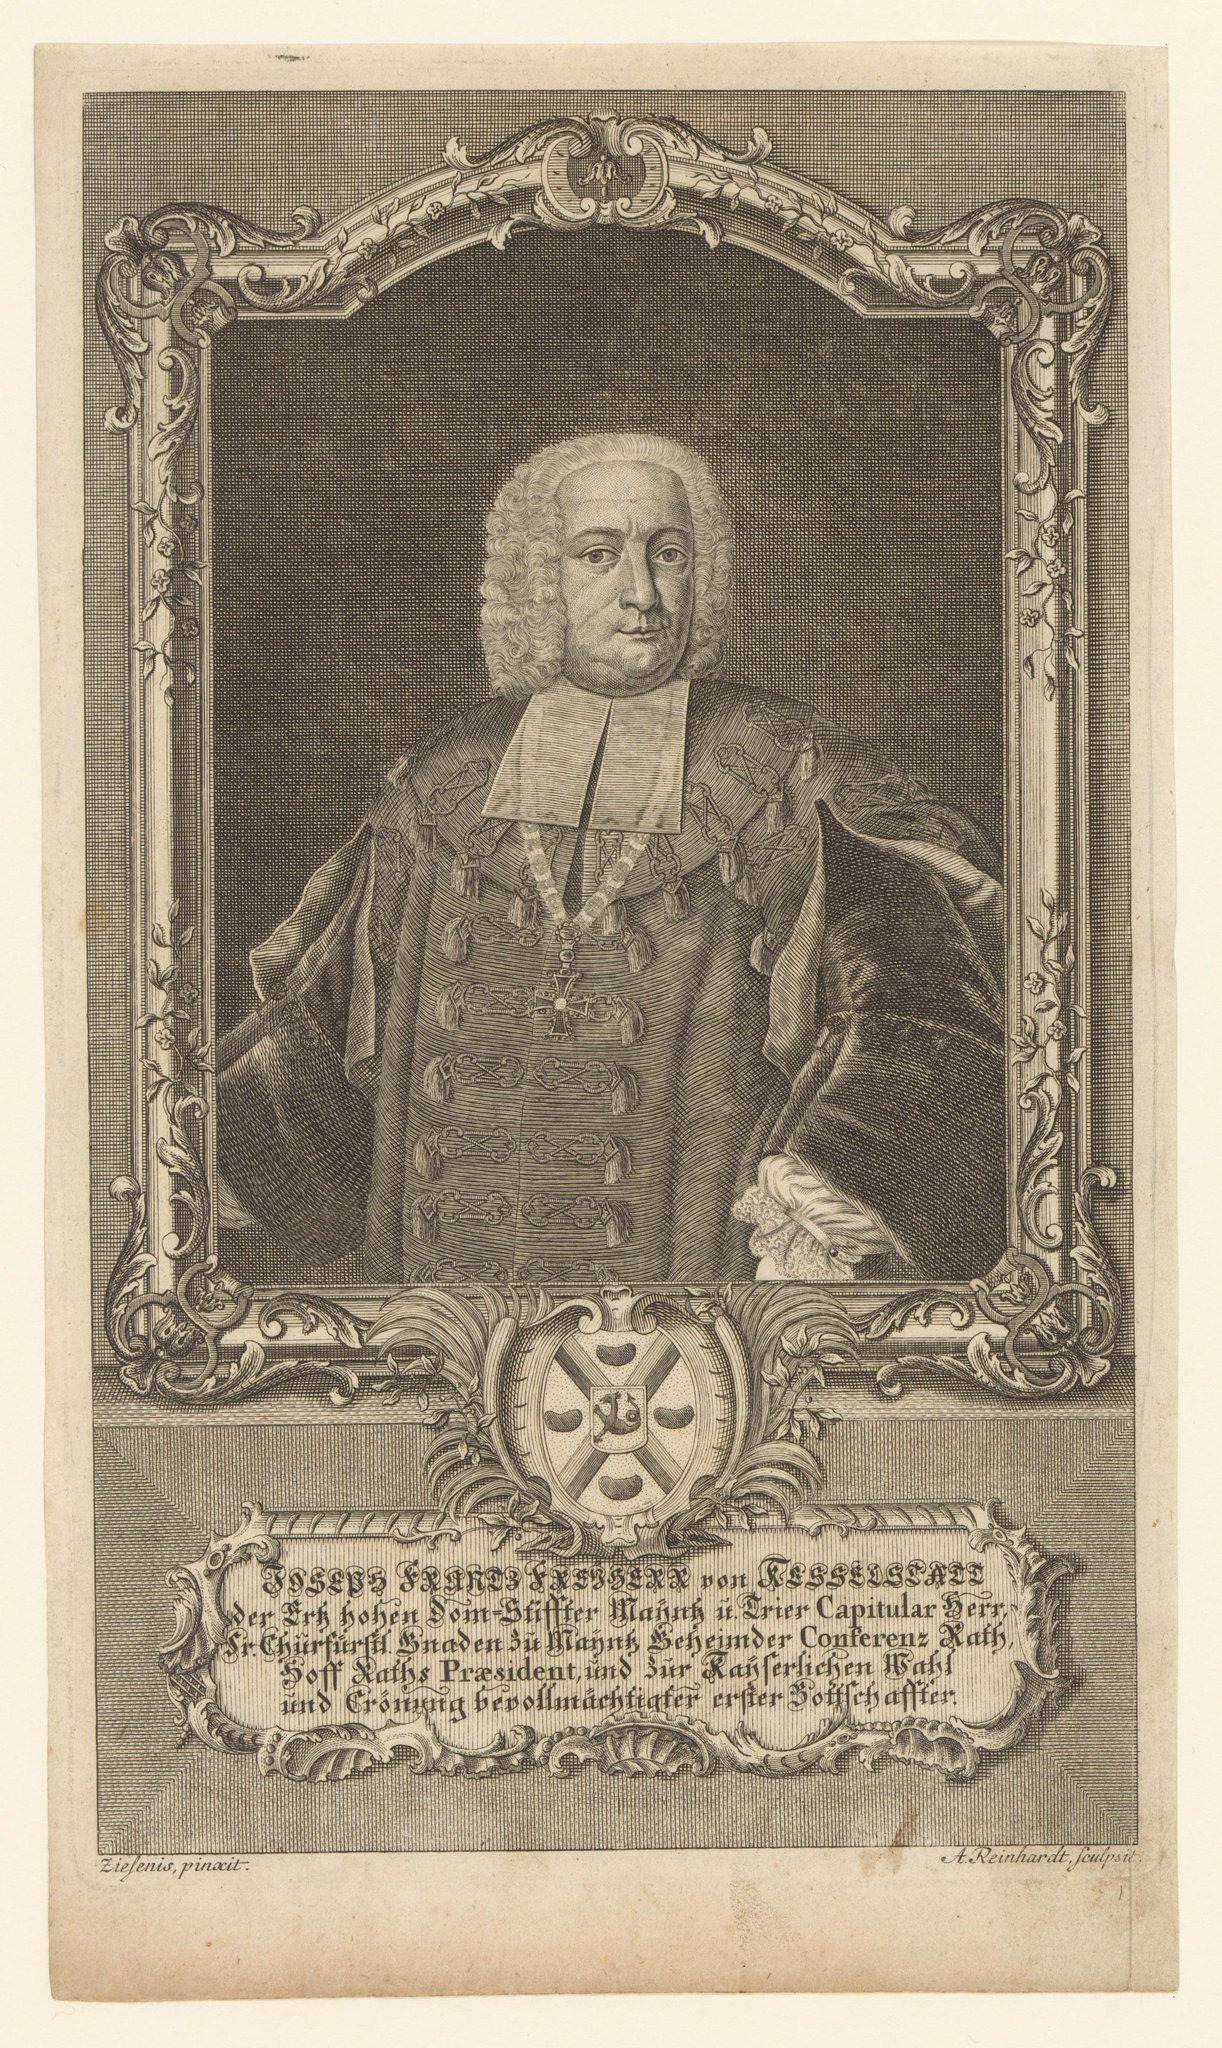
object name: print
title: Portret van Joseph Franz von Kesselstatt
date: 1686-1742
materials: paper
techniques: engraving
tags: historical persons, armorial bearing, heraldry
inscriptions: collector's mark: Lugt 2228